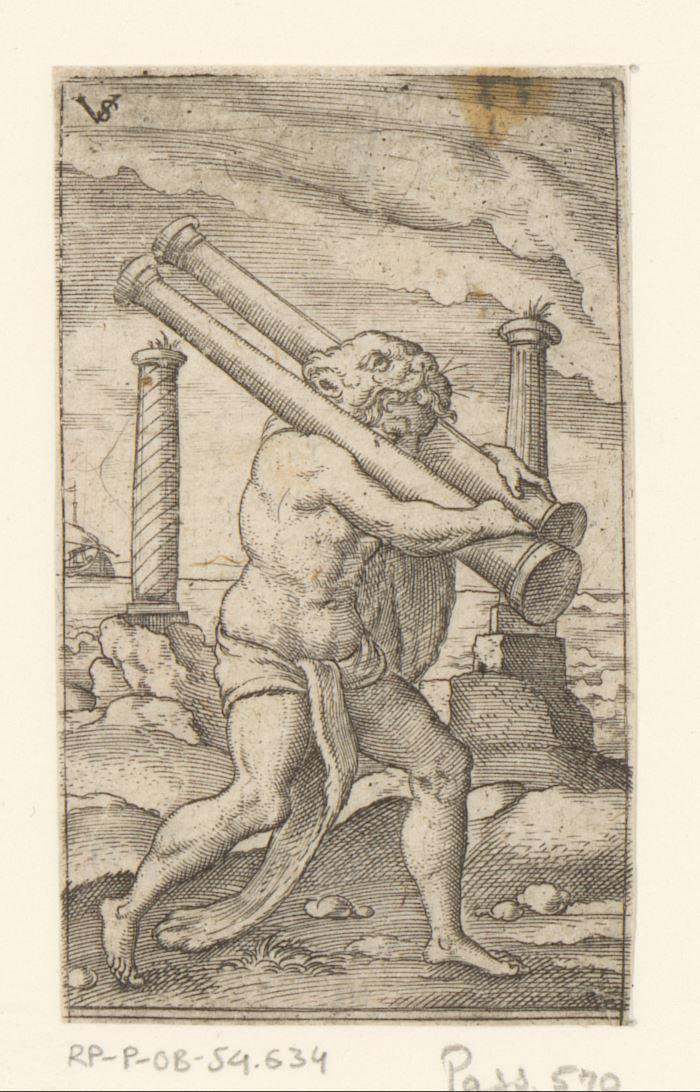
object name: print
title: Scènes uit het leven van Hercules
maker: virgilius solis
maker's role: draughtsman, print maker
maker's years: 1514-1562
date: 1524-1562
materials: paper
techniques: engraving, etching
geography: nuremberg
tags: hercules carrying the pillars which bear his name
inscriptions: collector's mark: Lugt 2228, number: ‘65’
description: Prent maakt deel uit van een reeks bestaande uit vier prenten met scènes uit het leven van Hercules.